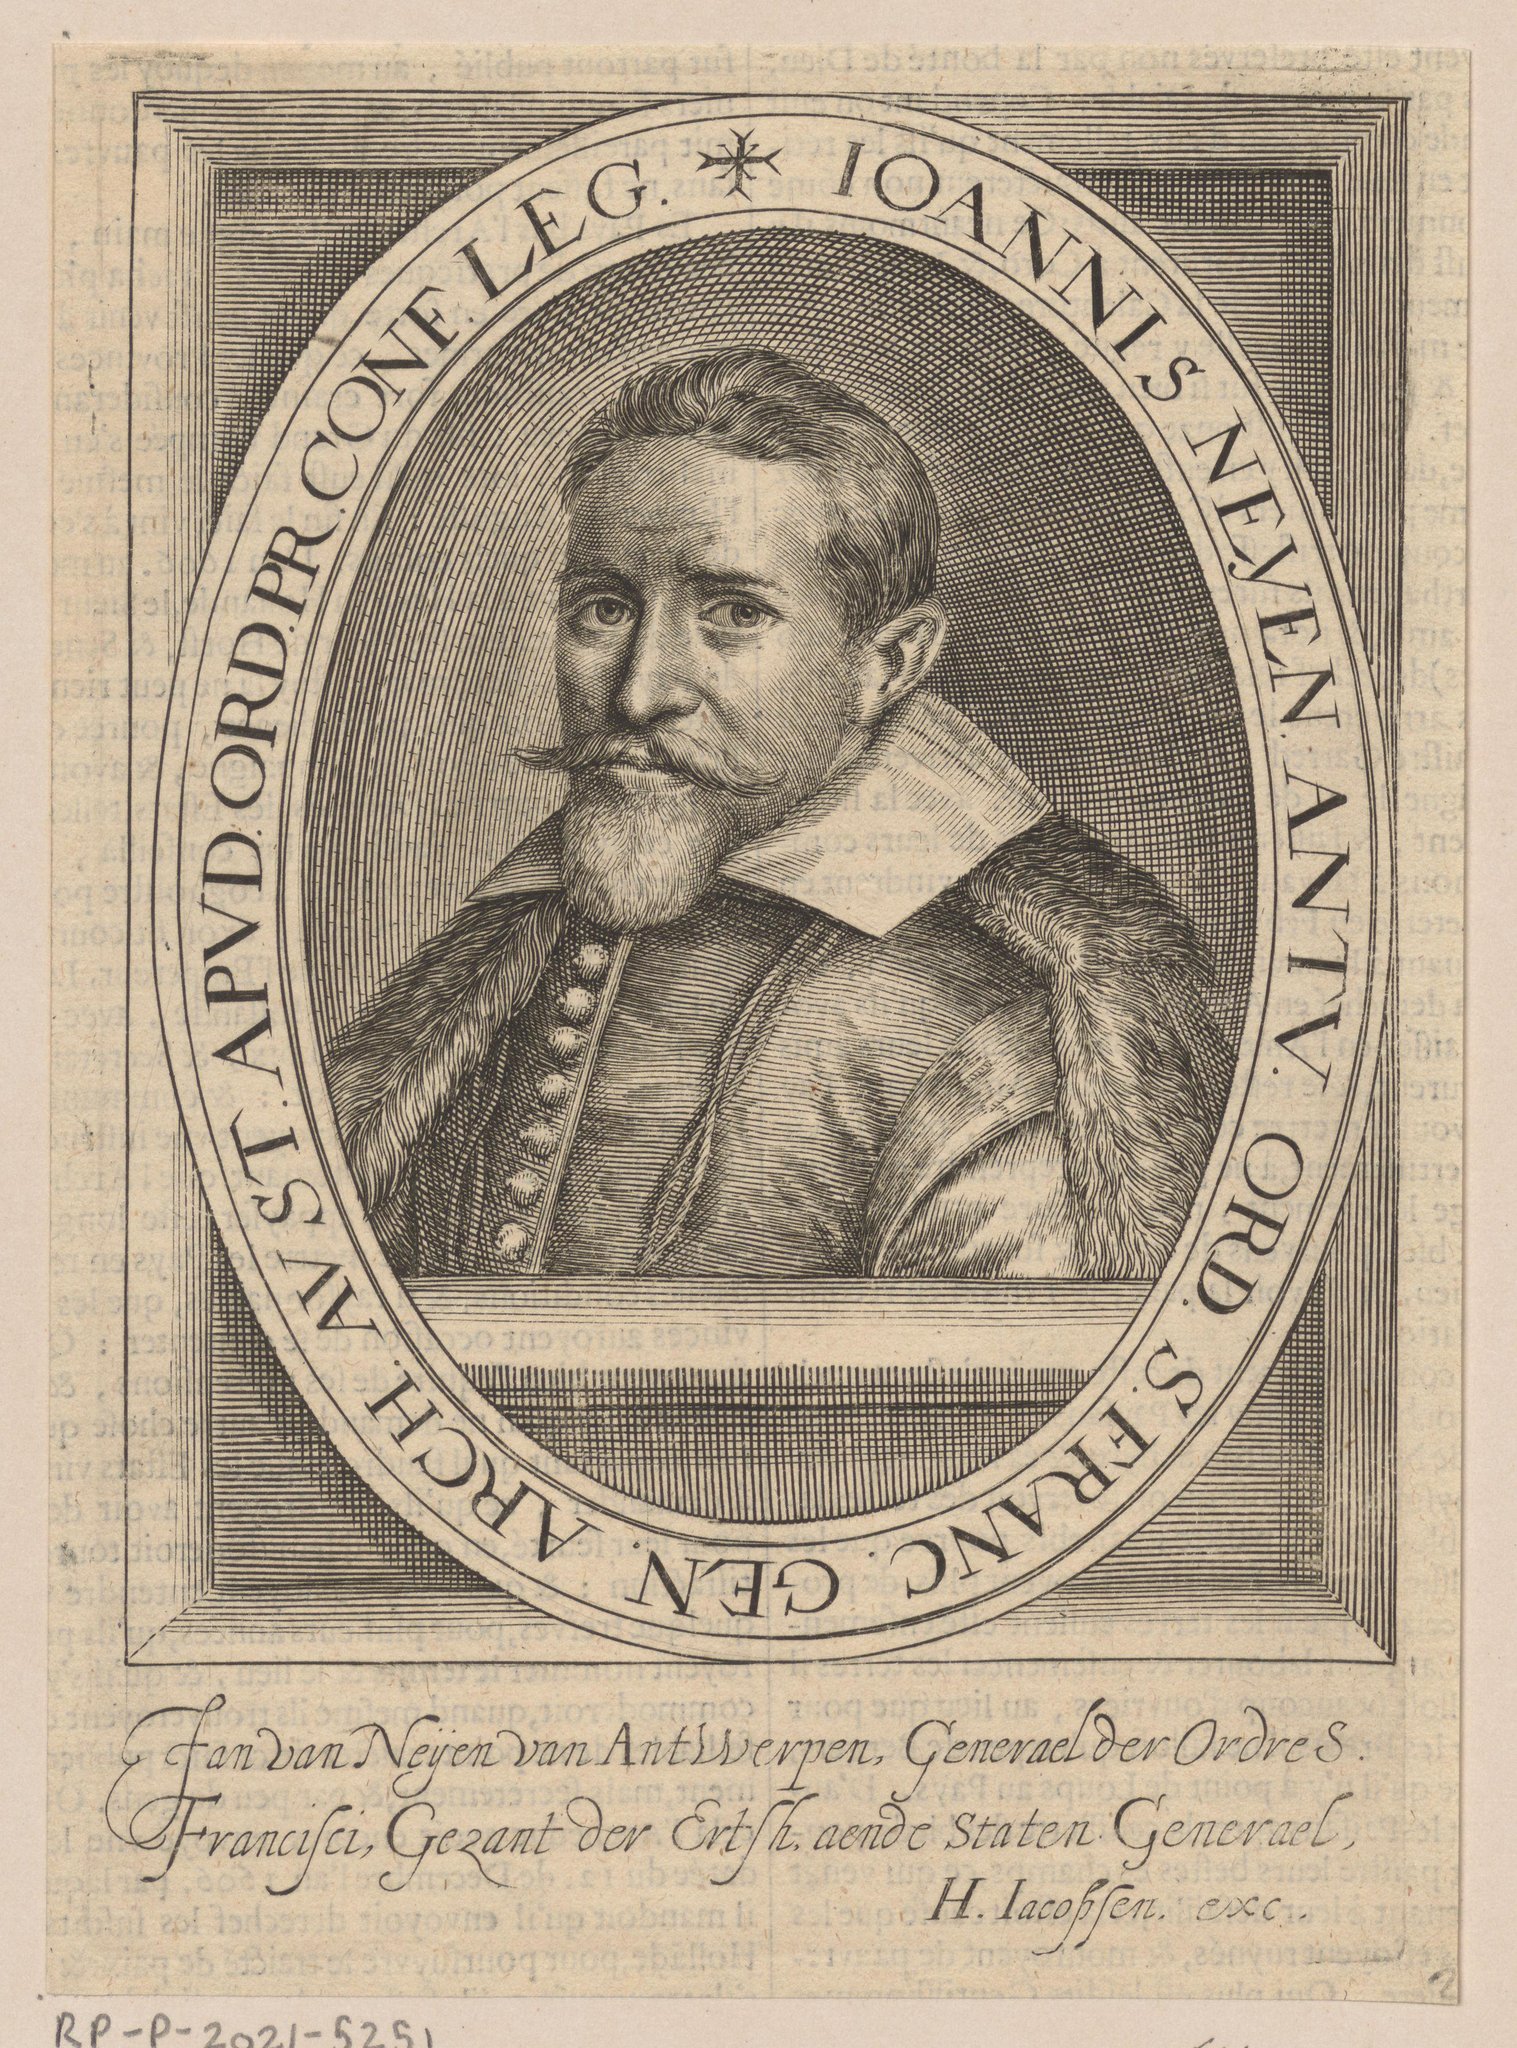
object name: book illustration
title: Portret van Jan Neyen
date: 1618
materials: paper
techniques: engraving, letterpress printing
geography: the hague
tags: antwerp, historical persons, diplomacy, diplomat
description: Prent uit: Meteren, Emanuel van. L'histoire des Pays-Bas d'Emanuel de Meteren (...). Den Haag: Hillebrant Jacobsz. van Wouw I, 1618. Prent mogelijk ook gebruikt in eerdere en latere edities.